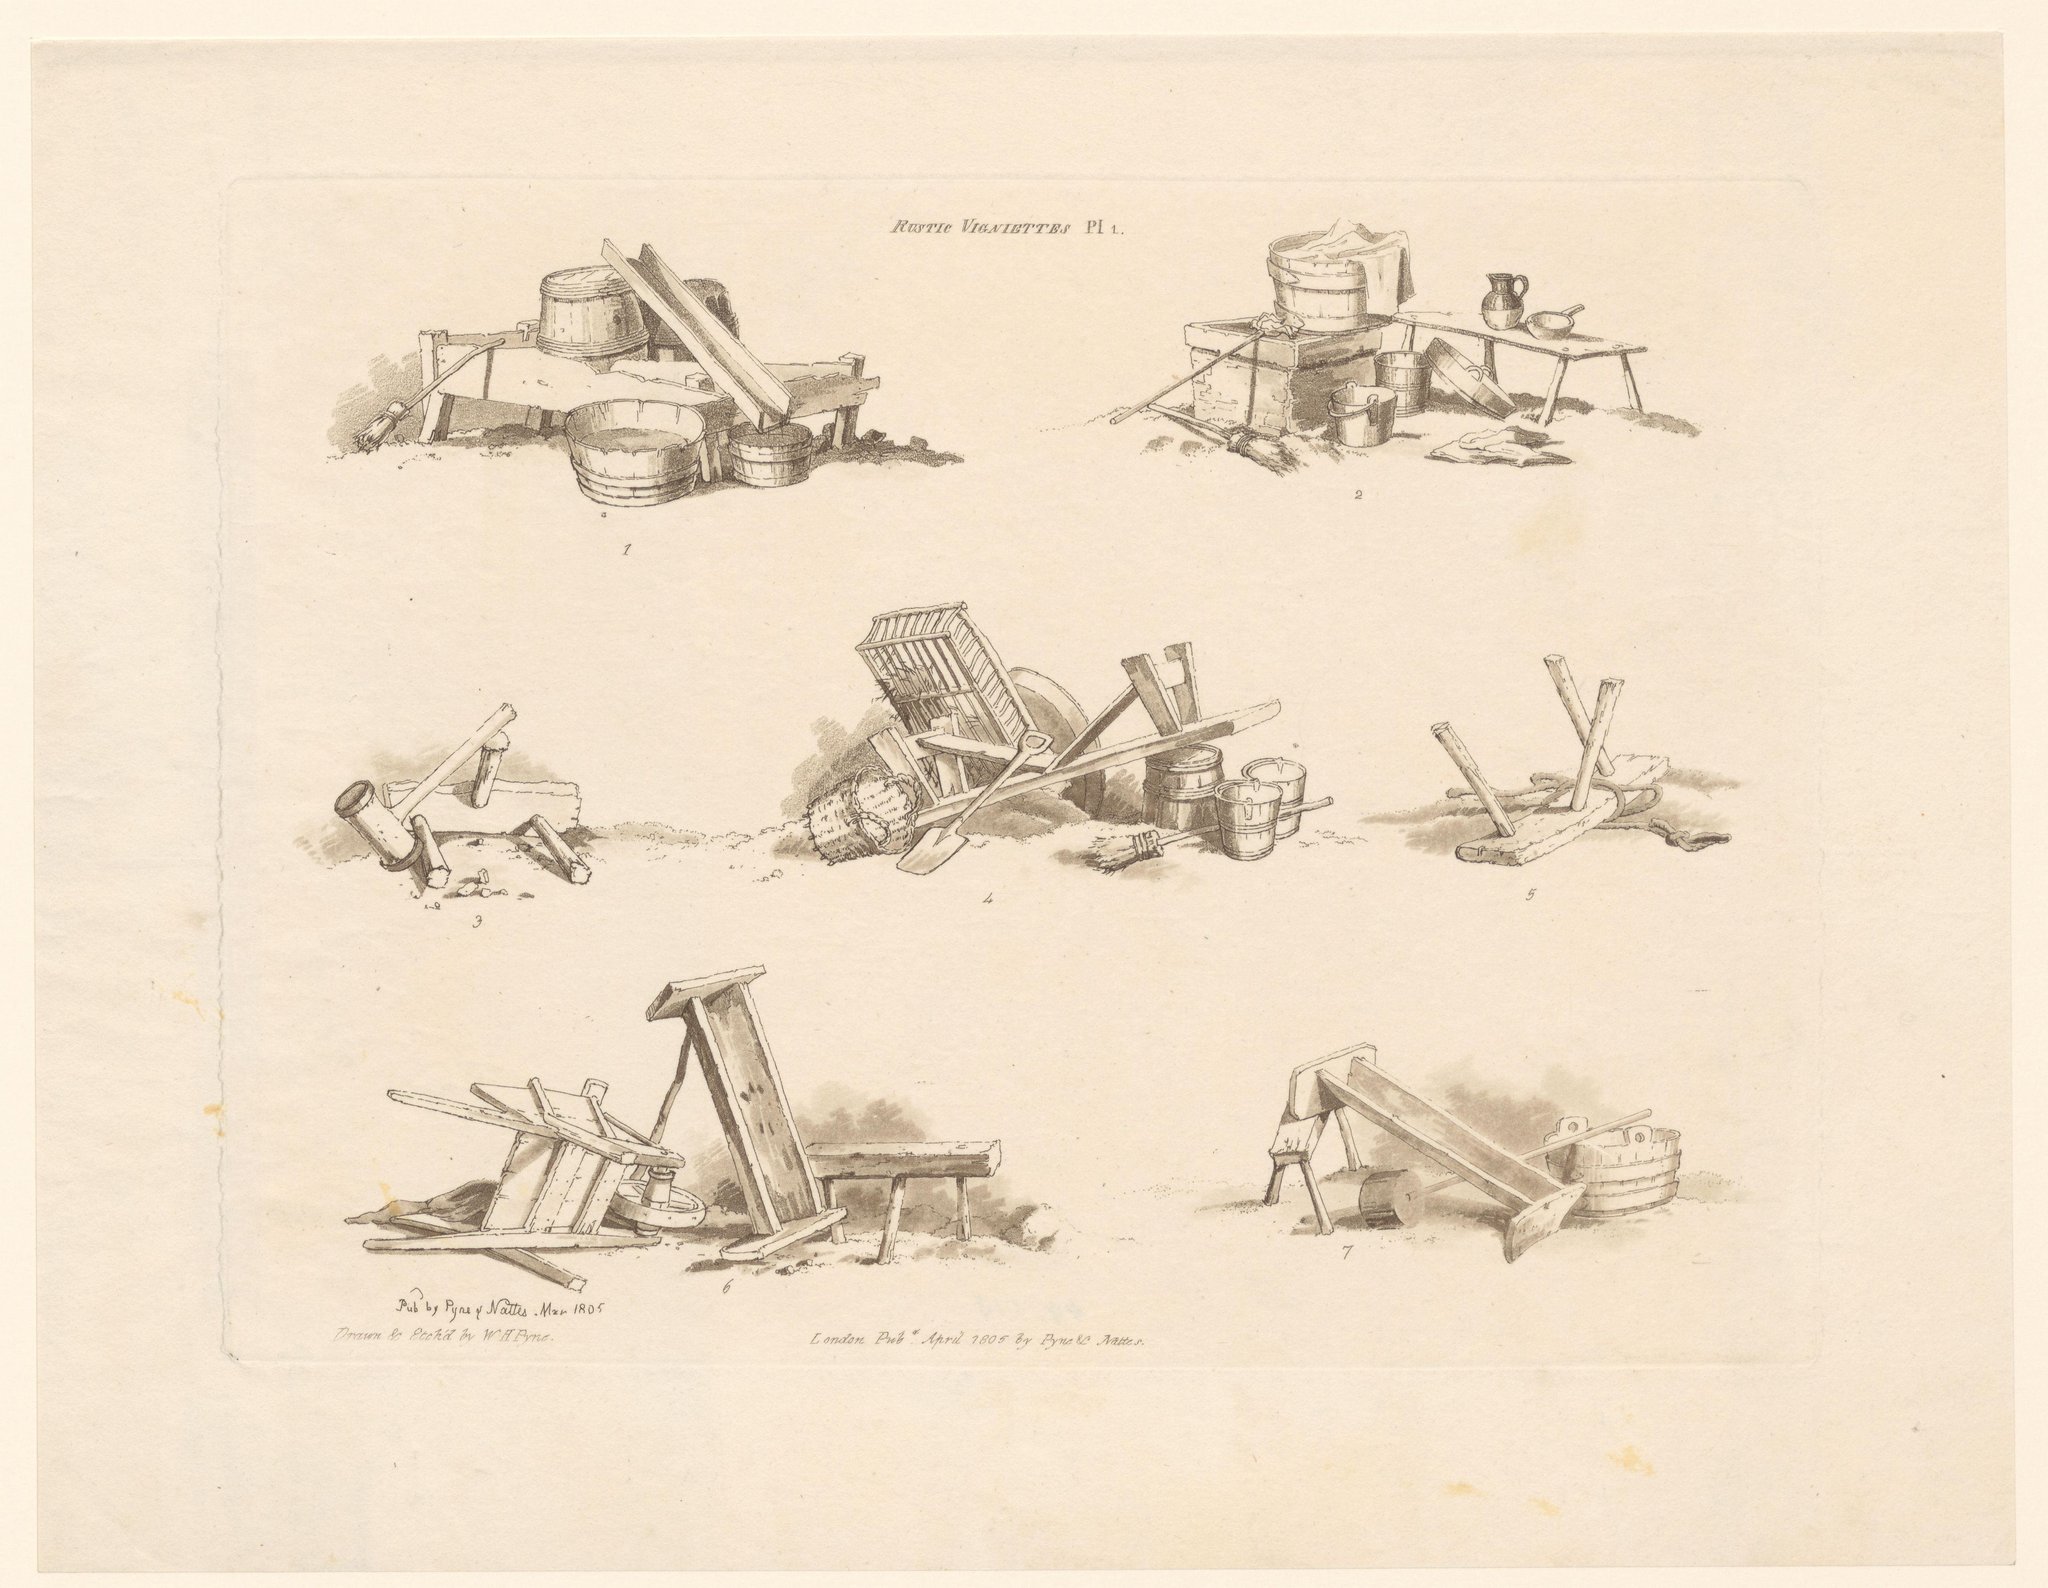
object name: print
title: Rustic Vigniettes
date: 1805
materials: paper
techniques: aquatint, etching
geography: london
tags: tools and machines ~ building, wooden container: barrel, cask, bucket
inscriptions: collector's mark: Lugt 2228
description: Prent gebruikt in: Pyne, William Henry. Microcosm: or, a picturesque delineation of the arts, agriculture, manufactures, &c. of Great Britain. Londen: William Henry Pyne & John Claude Nattes, 1806.